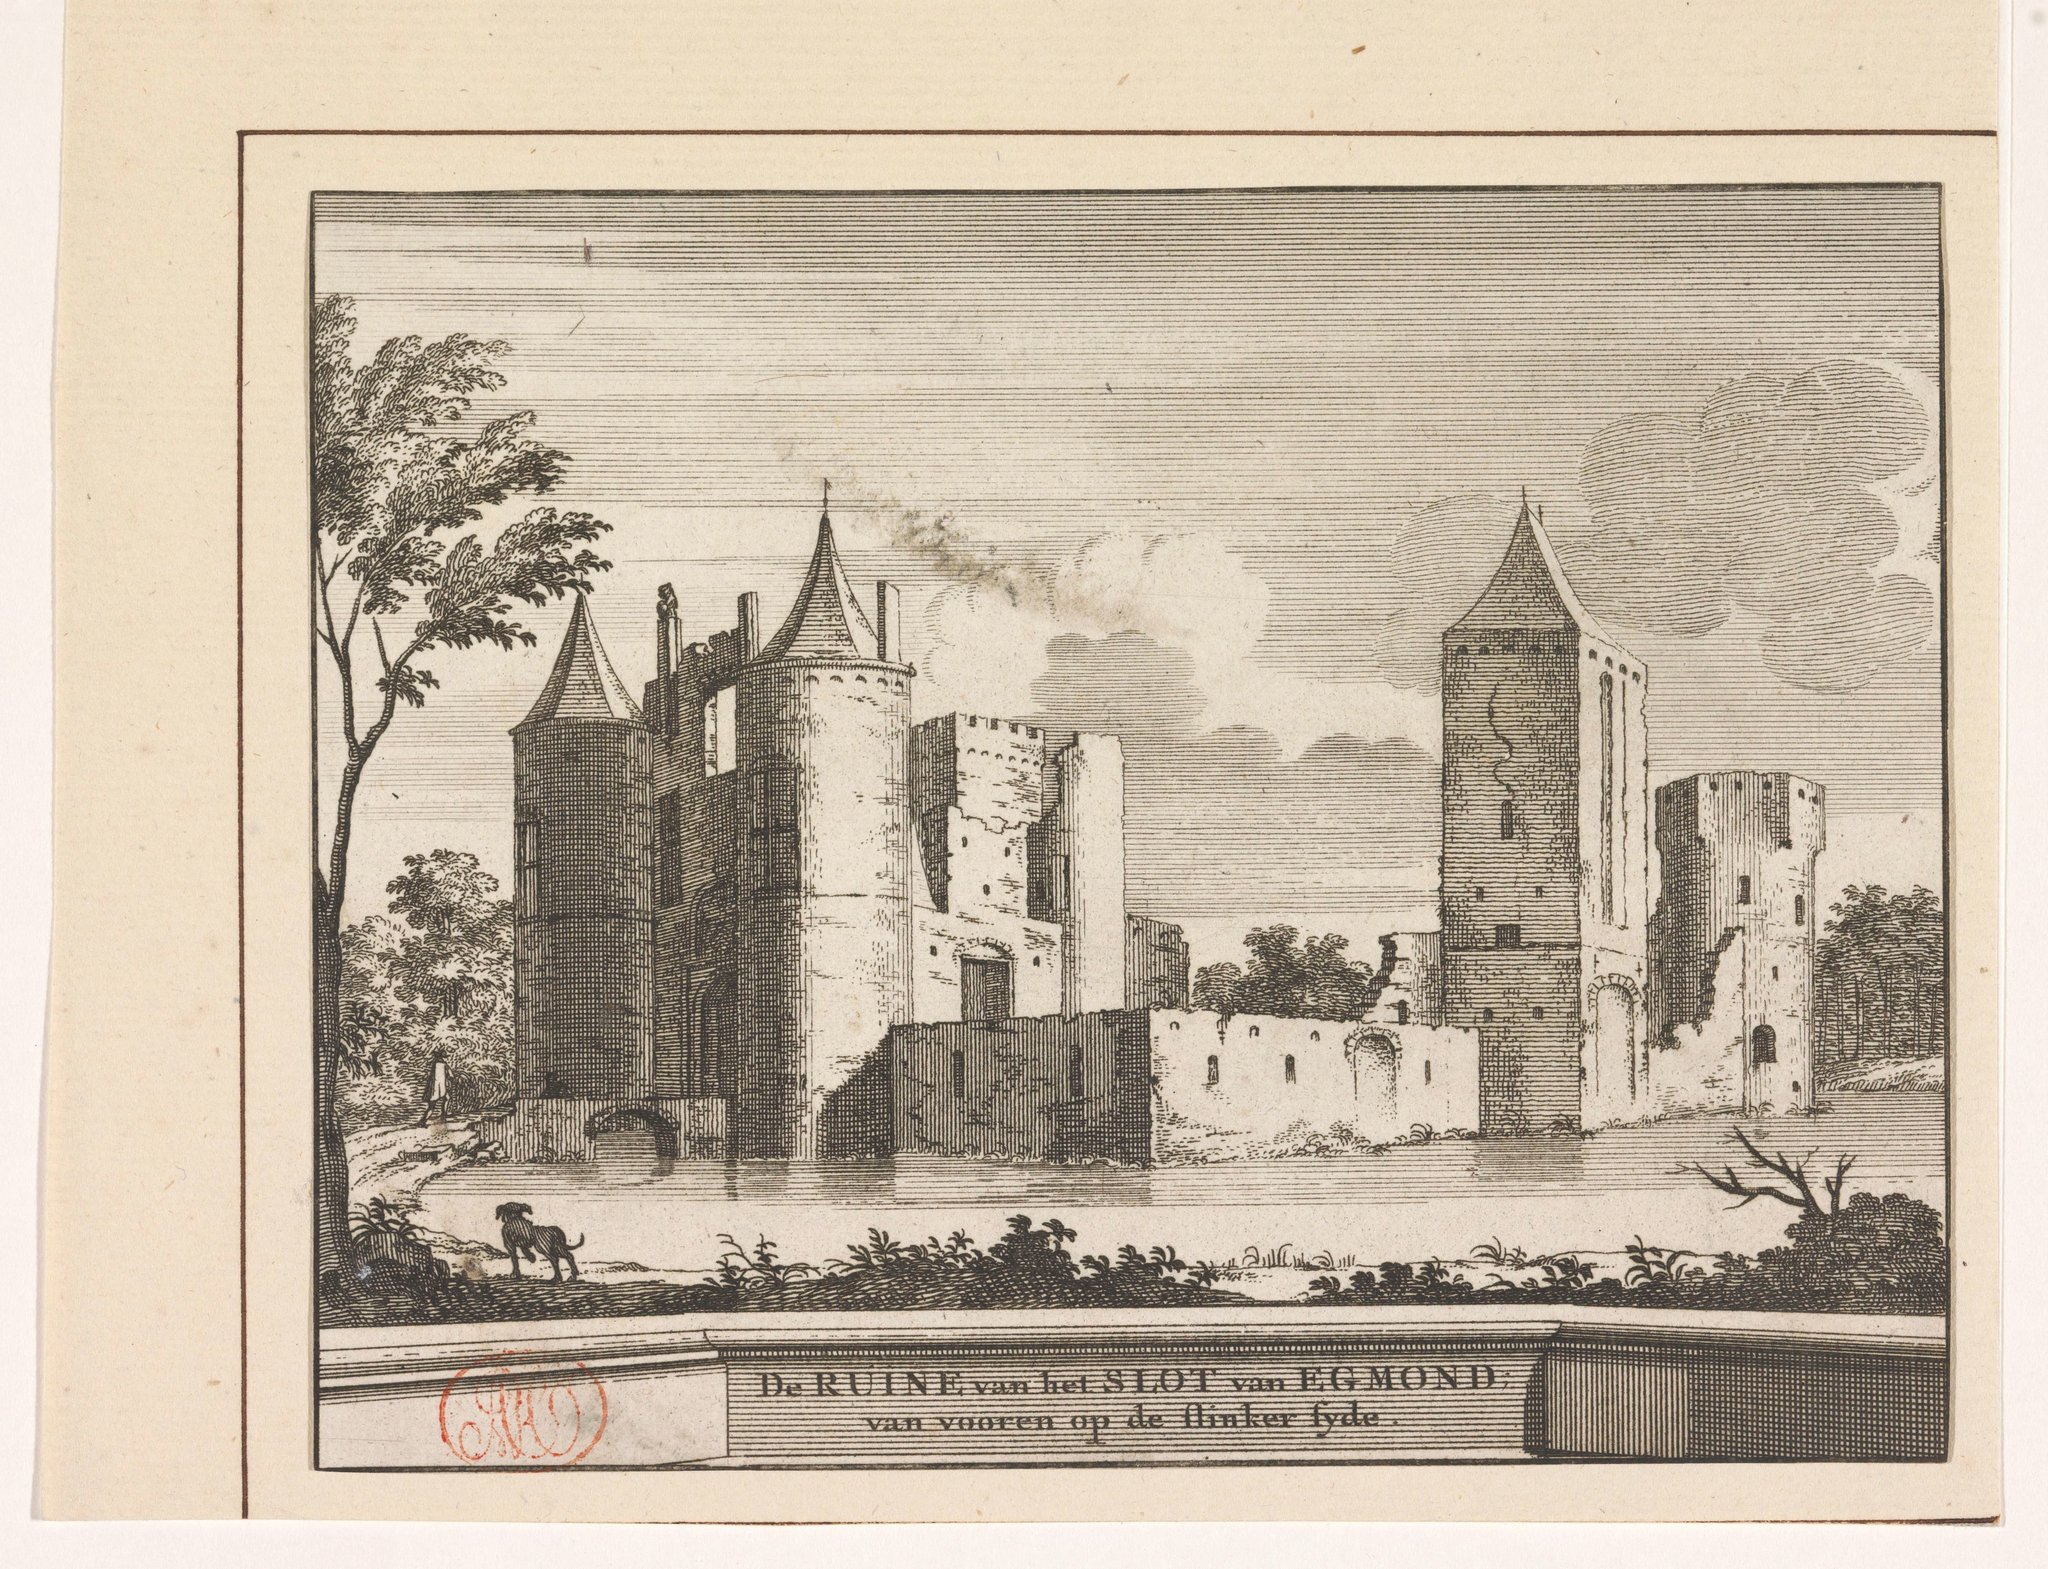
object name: book illustration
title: Gezicht op de ruïne van Kasteel Egmond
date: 1711-1774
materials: paper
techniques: engraving, etching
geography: amsterdam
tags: castle, bridge, ruin of a dwelling, house, castle, etc.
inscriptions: collector's mark: Lugt 195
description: Prent ook gebruikt in: Smids, Ludolf. Schatkamer der Nederlandsse oudheden; of woordenboek, behelsende Nederlands steden en dorpen, kasteelen, sloten en heeren huysen (…). Amsterdam: Pieter de Coup, 1711, tussen p. 78 en 79. Het is ook mogelijk dat deze prent uit de tweede (1737) of derde (1774) druk komt, of uit een uitgave met alleen de prenten: Nederlandsche oudheden, bestaande in zestig verbeeldingen (...) gelegen in Holland, 't Sticht van Utrecht en Gelderland enz. Amsterdam: Hendrik Bosch, 1721.